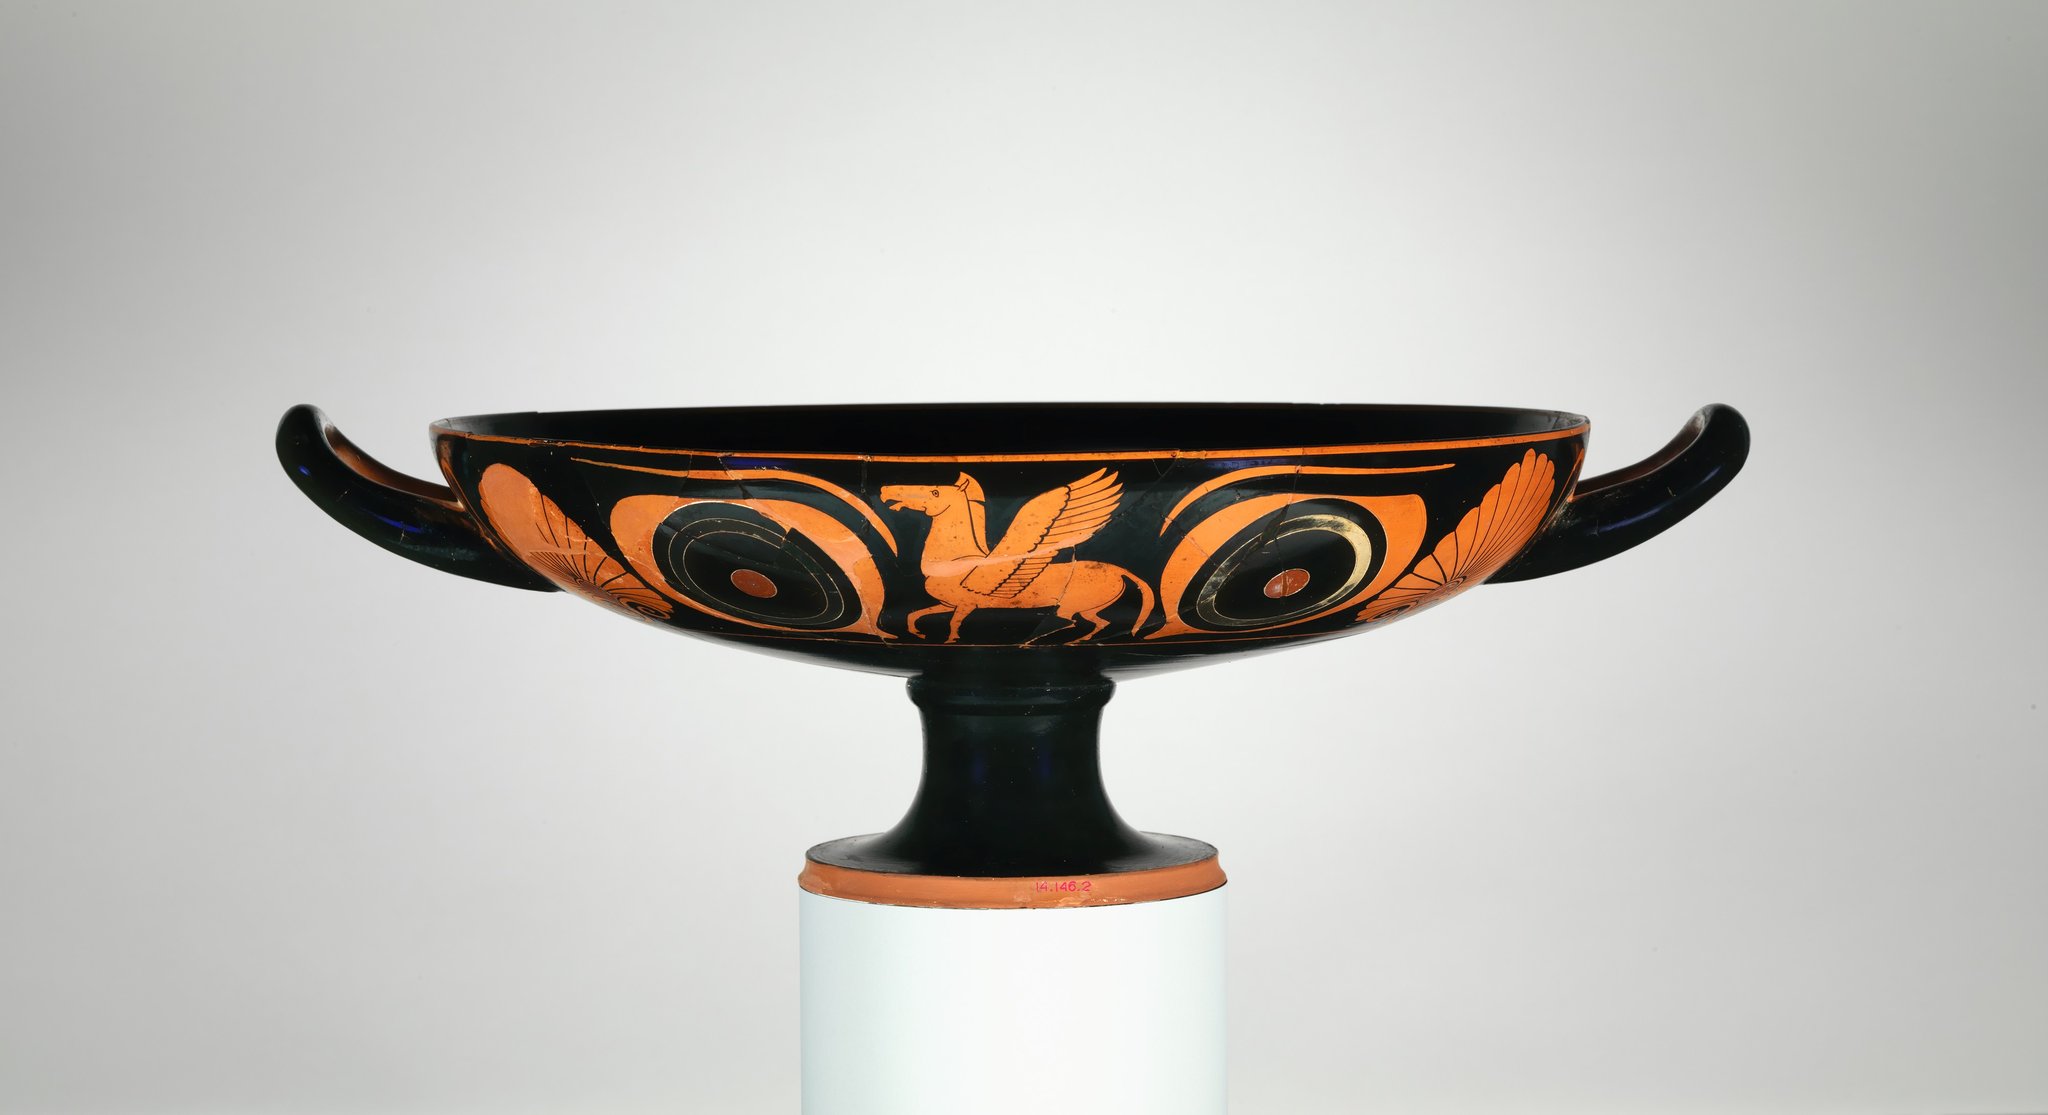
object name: kylix, bilingual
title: Terracotta kylix (drinking cup)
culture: greek, attic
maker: psiax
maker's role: artist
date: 520 BCE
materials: terracotta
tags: birds,pegasus,snakes